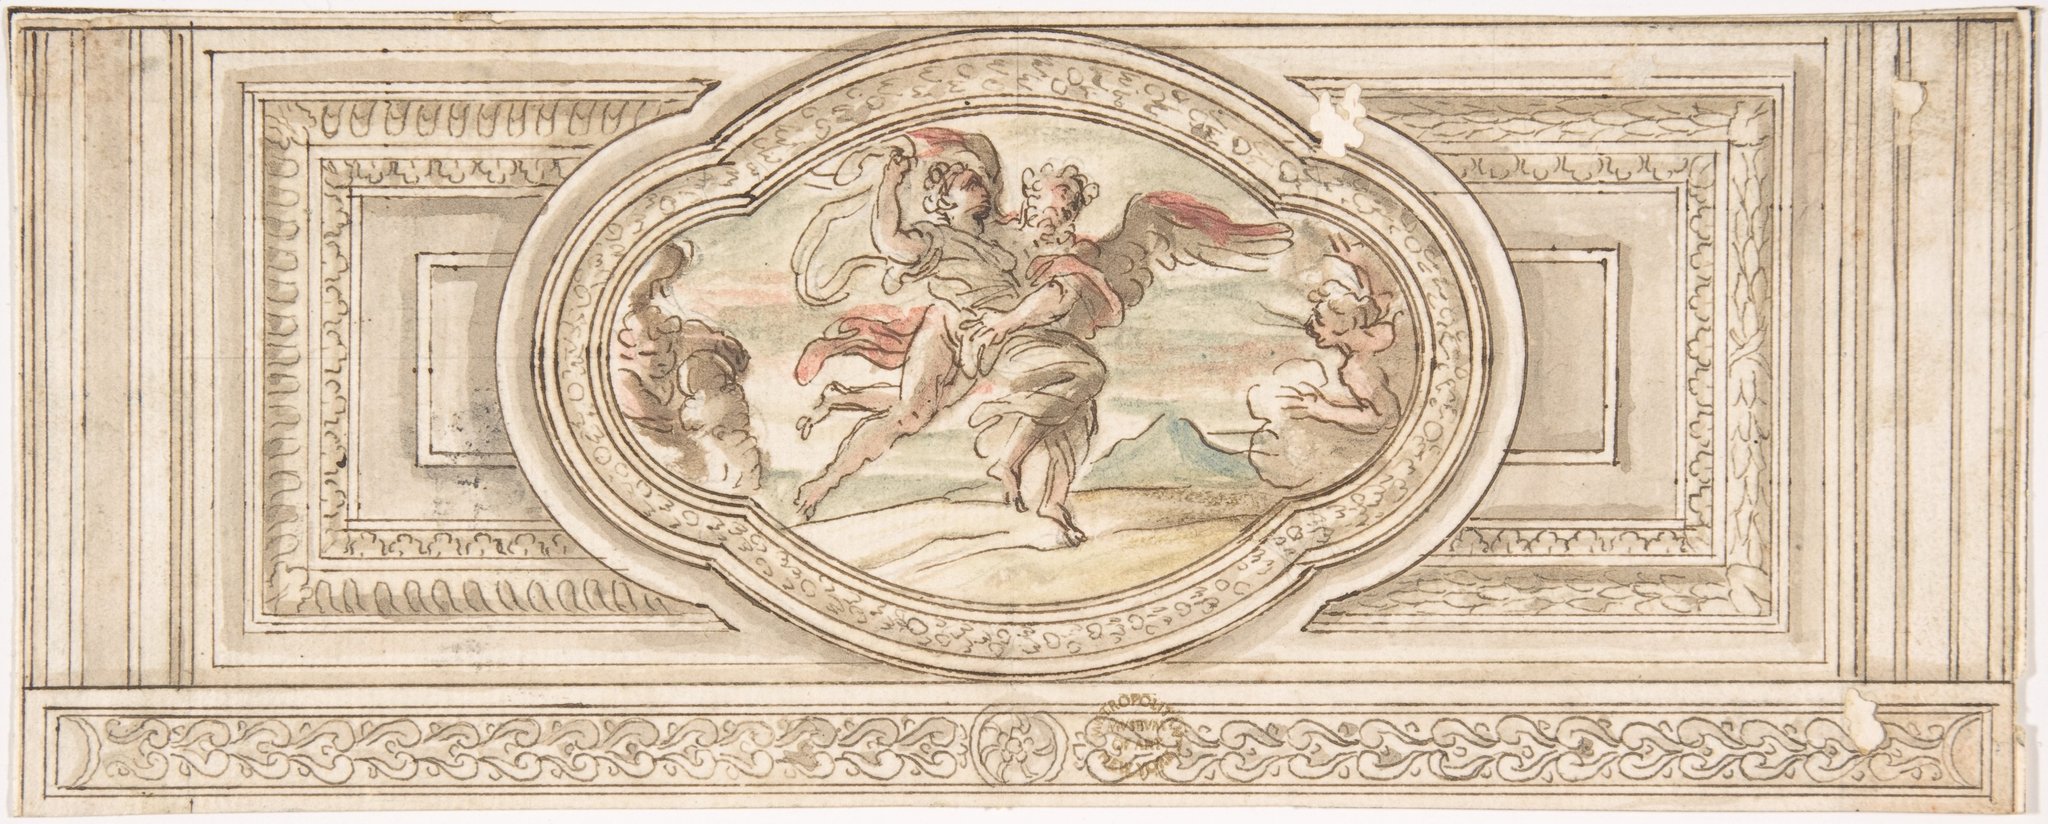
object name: drawing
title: Design for a Panel with a Depiction of Boreas Abducting Oreithyia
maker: anonymous, italian, roman-bolognese, 17th century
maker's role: artist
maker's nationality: italian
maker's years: 1600-1700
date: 1601-1700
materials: chalk, ink, paper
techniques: brush, pen, wash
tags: human figures